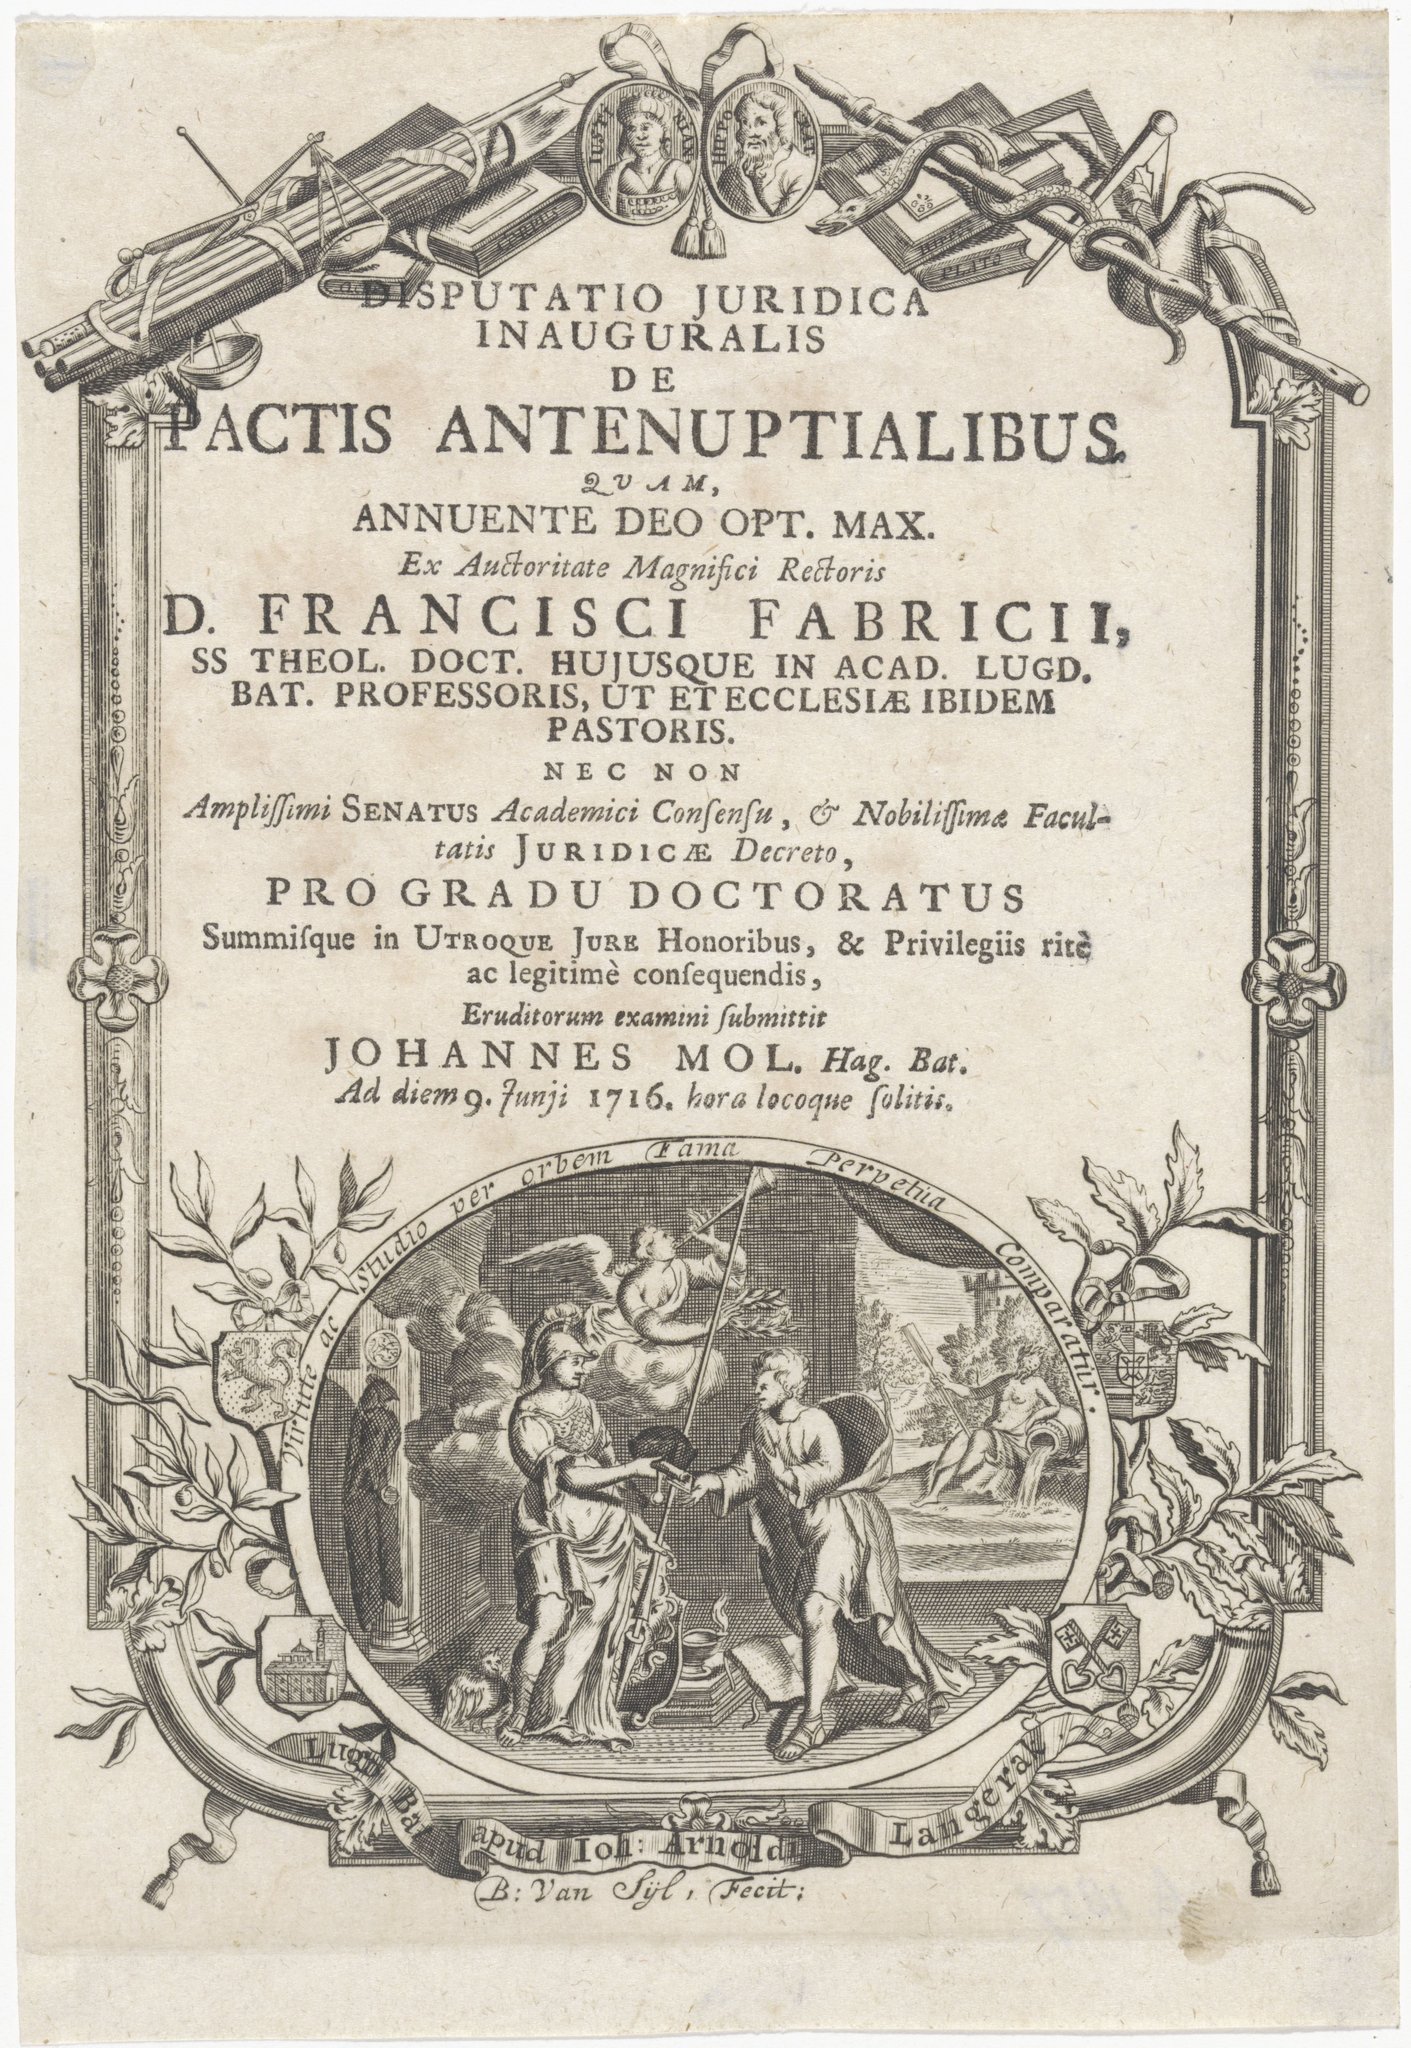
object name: print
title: Titelpagina voor: Johannes Mol, Disputatio juridica inauguralis de pactis antenuptialibus, 1716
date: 1716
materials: paper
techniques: engraving, etching, letterpress printing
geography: leiden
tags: snakes, minerva as patroness, scales, fama as roman personification, book, container of glass: bottle, jar, vase, calculating-instruments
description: Drukkersmerk van de Leidse drukker Johan Arnold Langerak, voorstellende Minerva die een bul met bijbehorende eretekenen uitreikt aan een jonge man. De Faam vliegt daarboven. Op de achtergrond een riviergod. Rondom het ovaal de zinspreuk "Virtute ac studio per orbem Fama perpetitia comparatur". Daaromheem eiken- en olijventakken en vier wapens, waaronder dat van de stad Leiden. Op een banderolle de naam van Langerak. In de omlijsting een fasces, weegschaal, meetinstrumenten, een alambic, een slang, boeken met teksten uit de klassieke Oudheid en de portretten van Justinianus en Hippocrates. Binnen de omlijsting in boekdruk de titel van de dissertatie waarop Johannes Mol aan de Leidse universiteit onder gezag van rector magnificus Franciscus Fabricius tot doctor in de beide rechten promoveerde op 9 juni 1716.